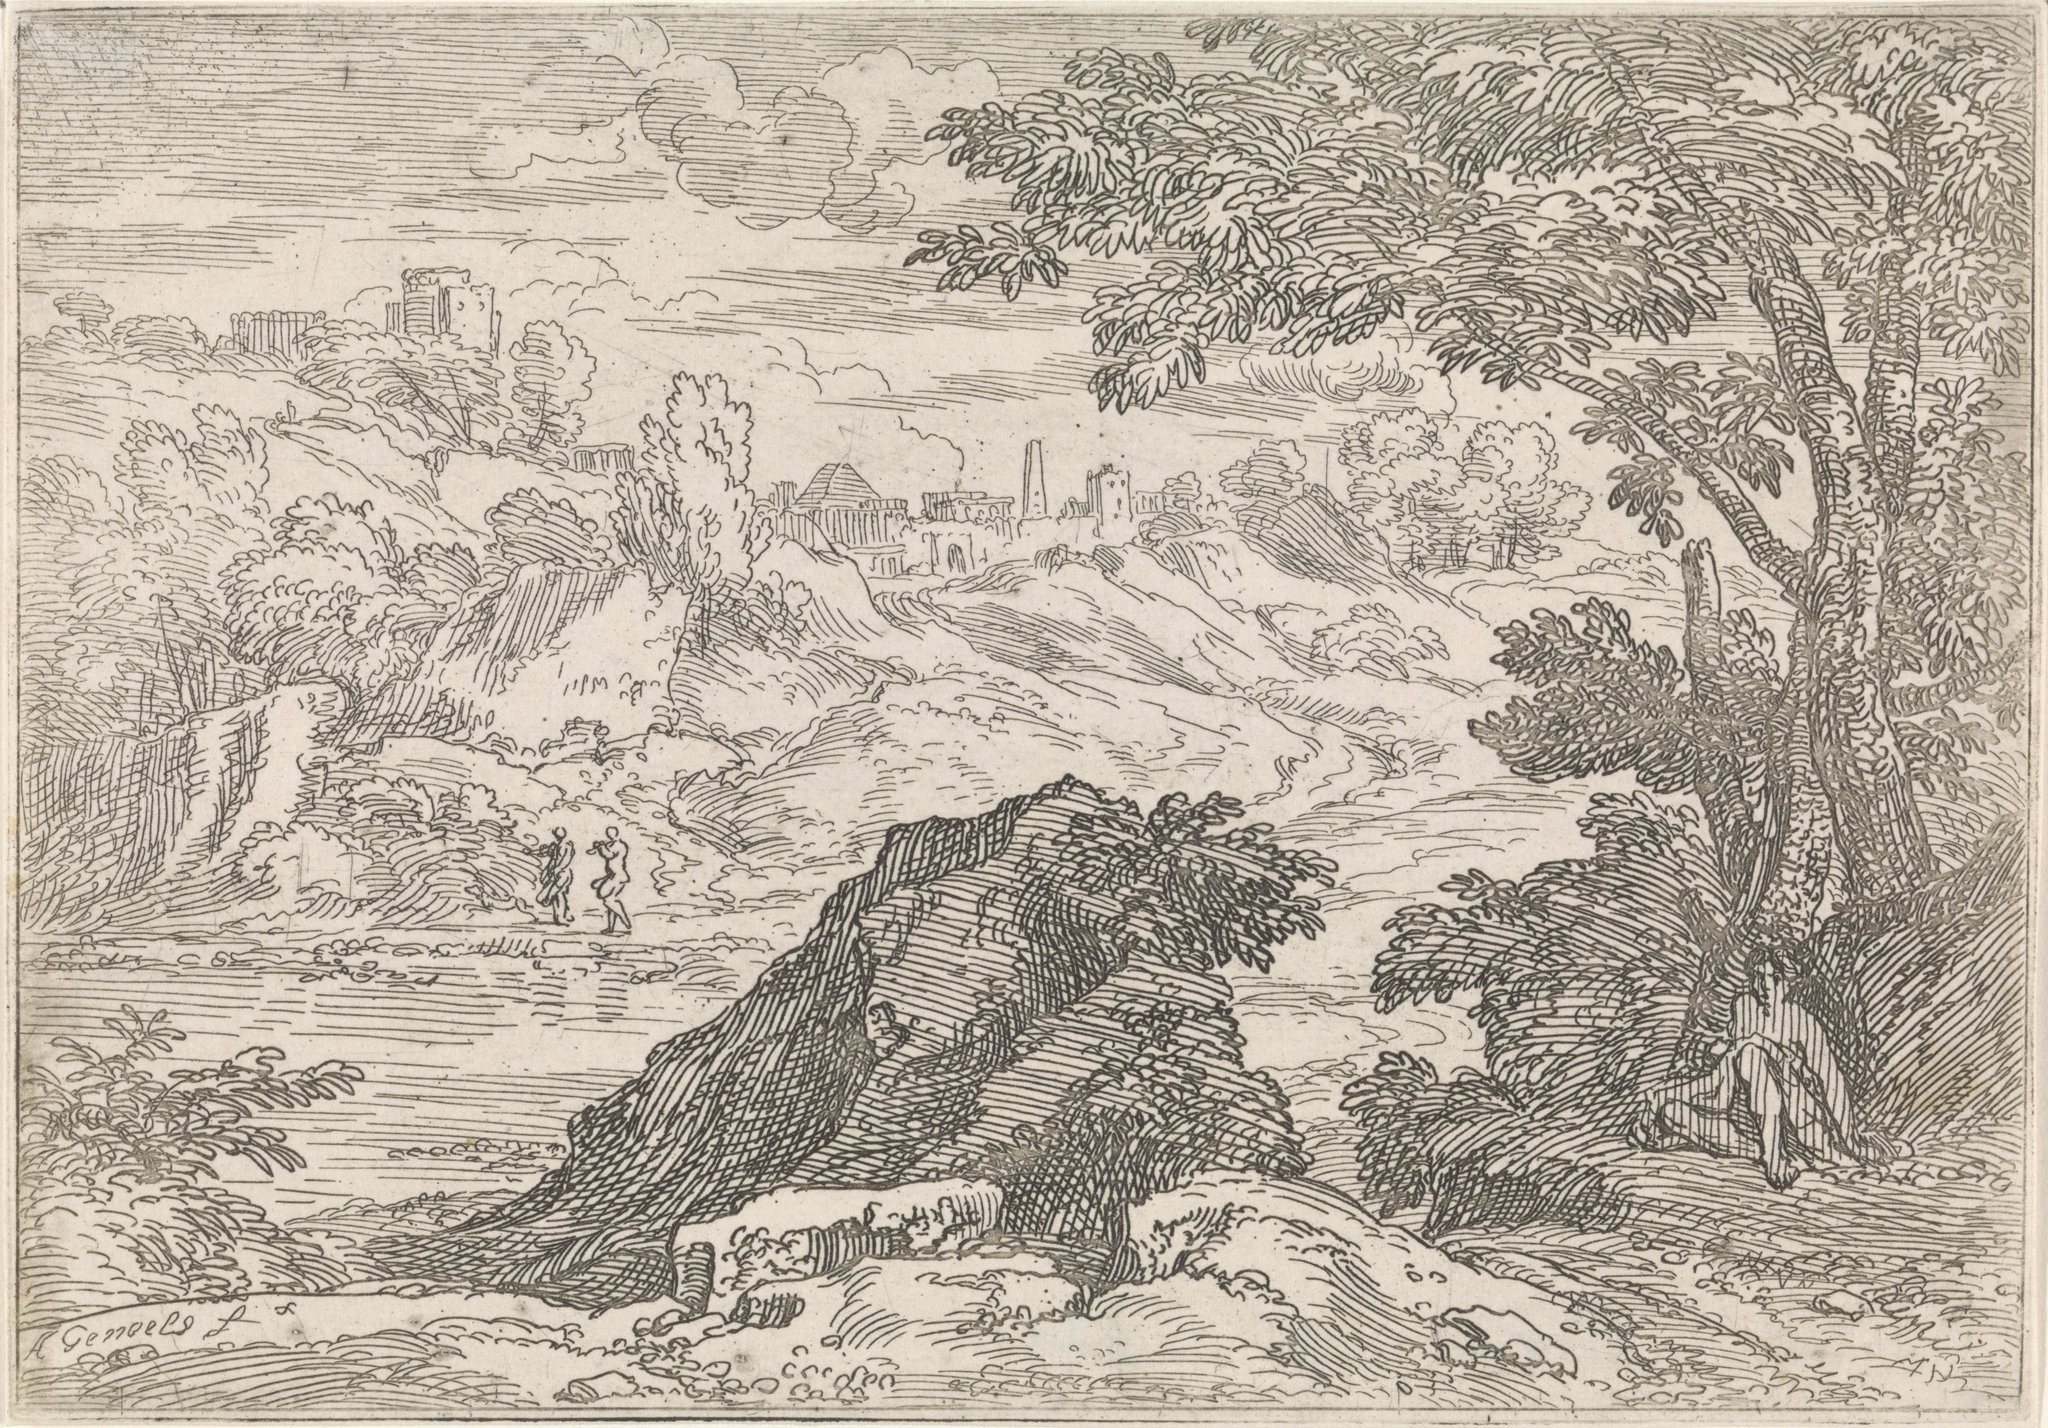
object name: print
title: Landschap met rivier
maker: abraham genoels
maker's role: draughtsman, print maker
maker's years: 1640-1723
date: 1650-1723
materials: paper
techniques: etching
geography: antwerp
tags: (high) hill, river (+ landscape with figures, staffage)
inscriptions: collector's mark: Lugt 240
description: Een heuvelachtig landschap met een rivier. Rechts op de voorgrond rust een halfnaakte man uit in de schaduw van een boom. De prent is deel van een serie van zes Arcadische landschappen.